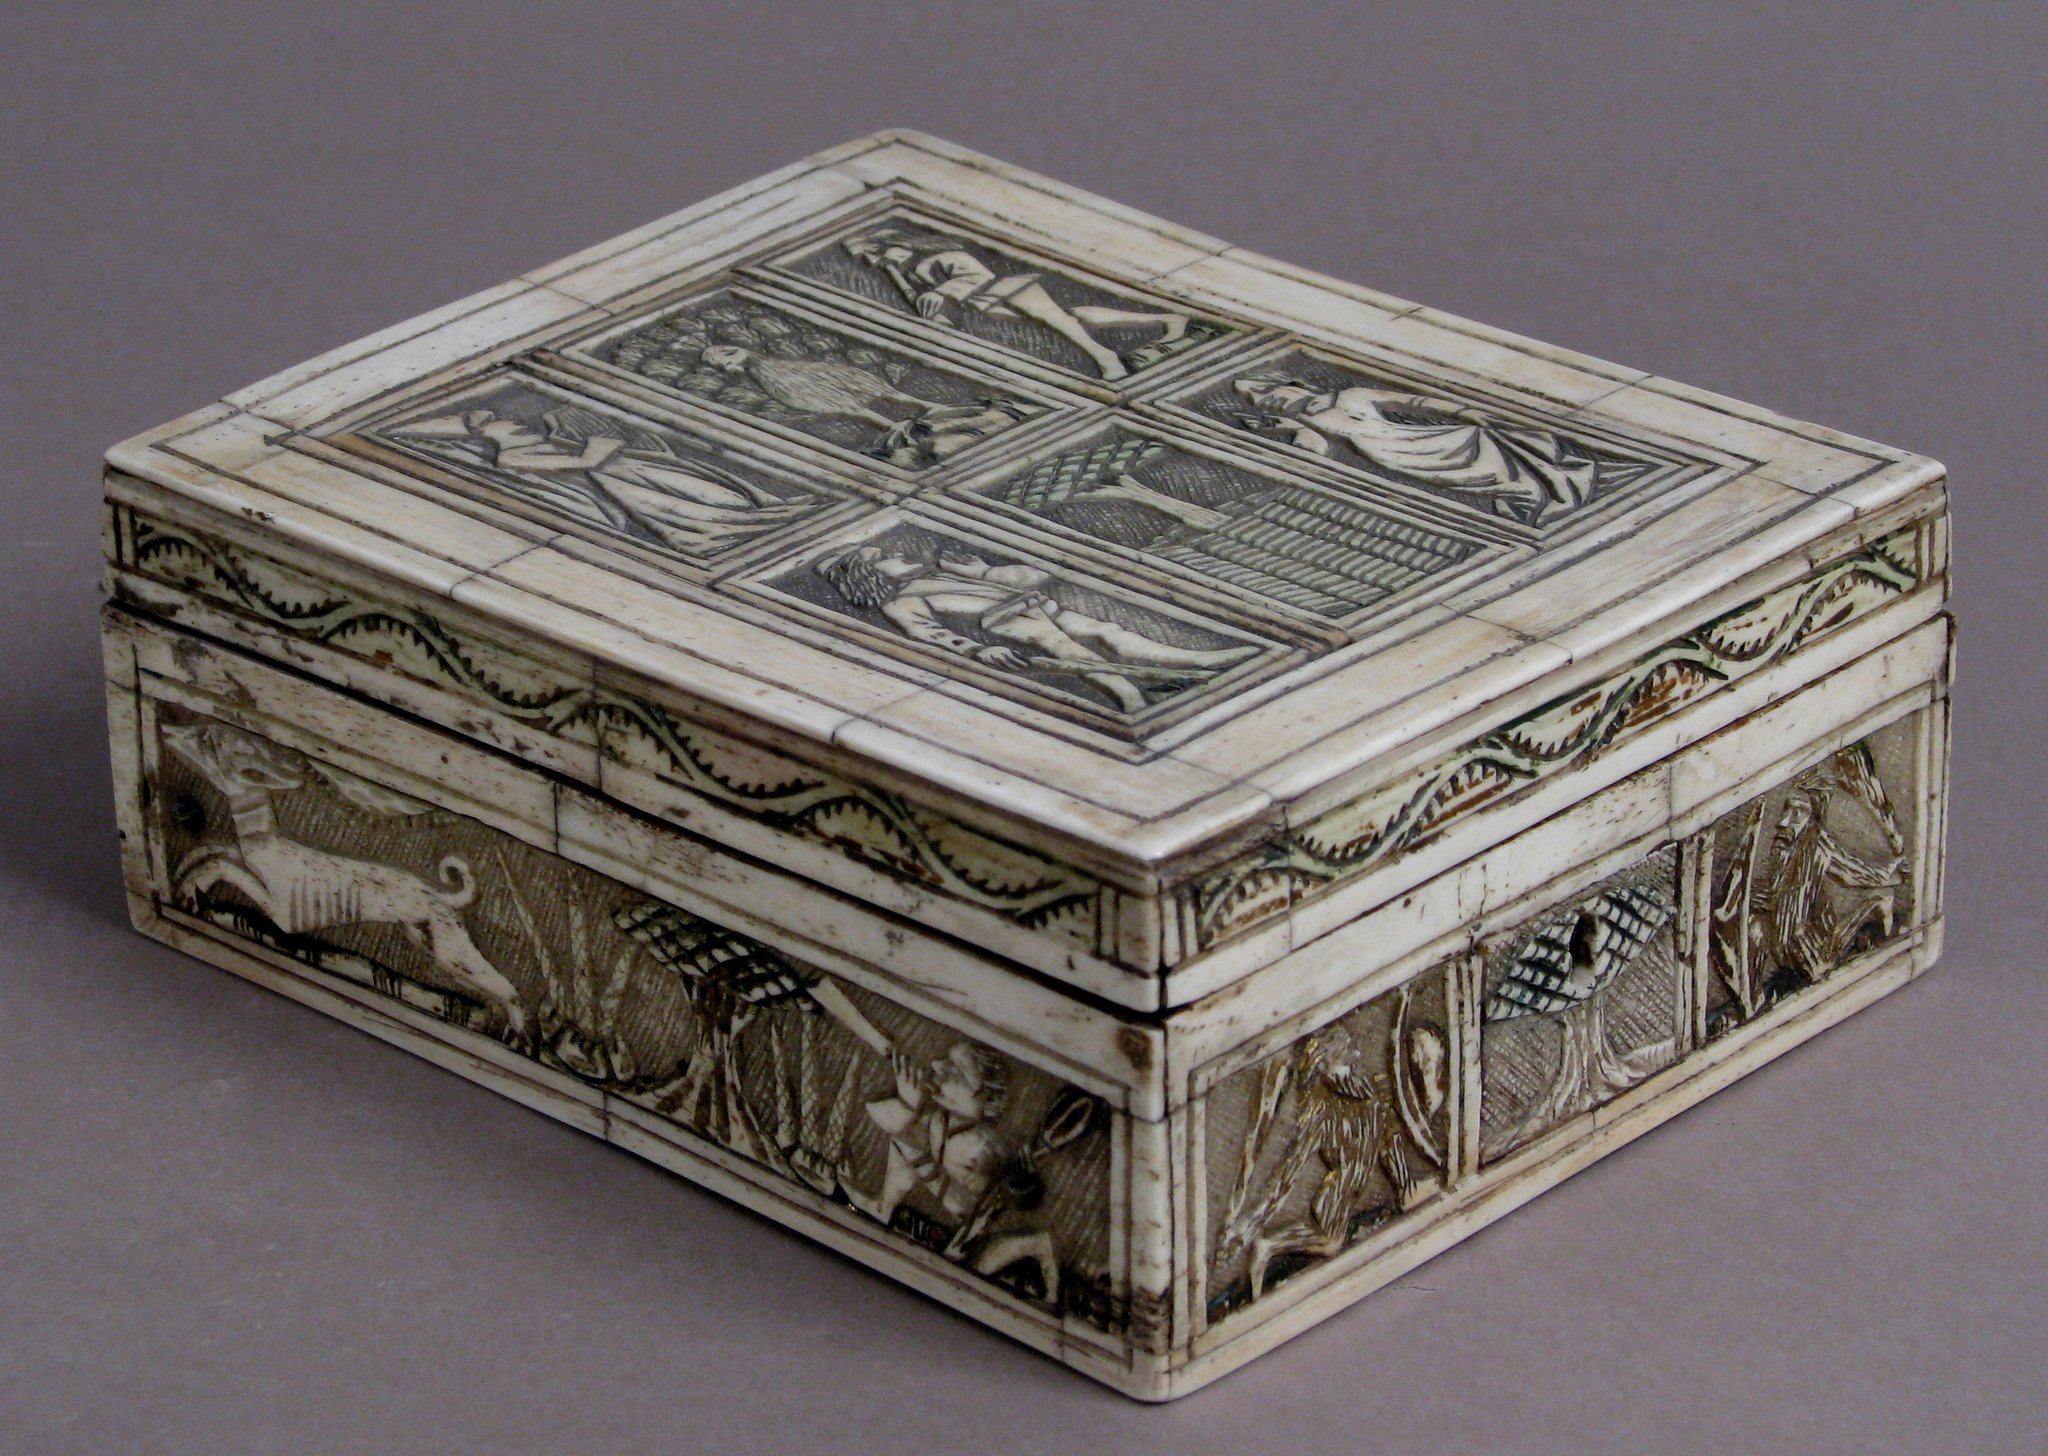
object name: game box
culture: french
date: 1401-1600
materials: bone, metal, paint, silk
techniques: gilding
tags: animals,weapons,hunting